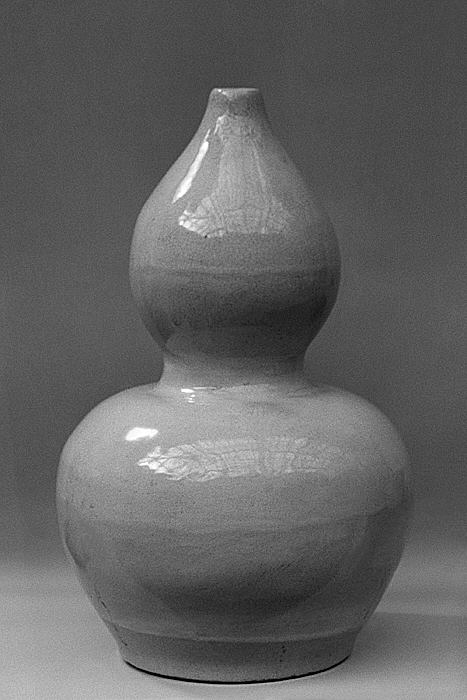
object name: vase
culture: chinese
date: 1368-1644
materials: glaze